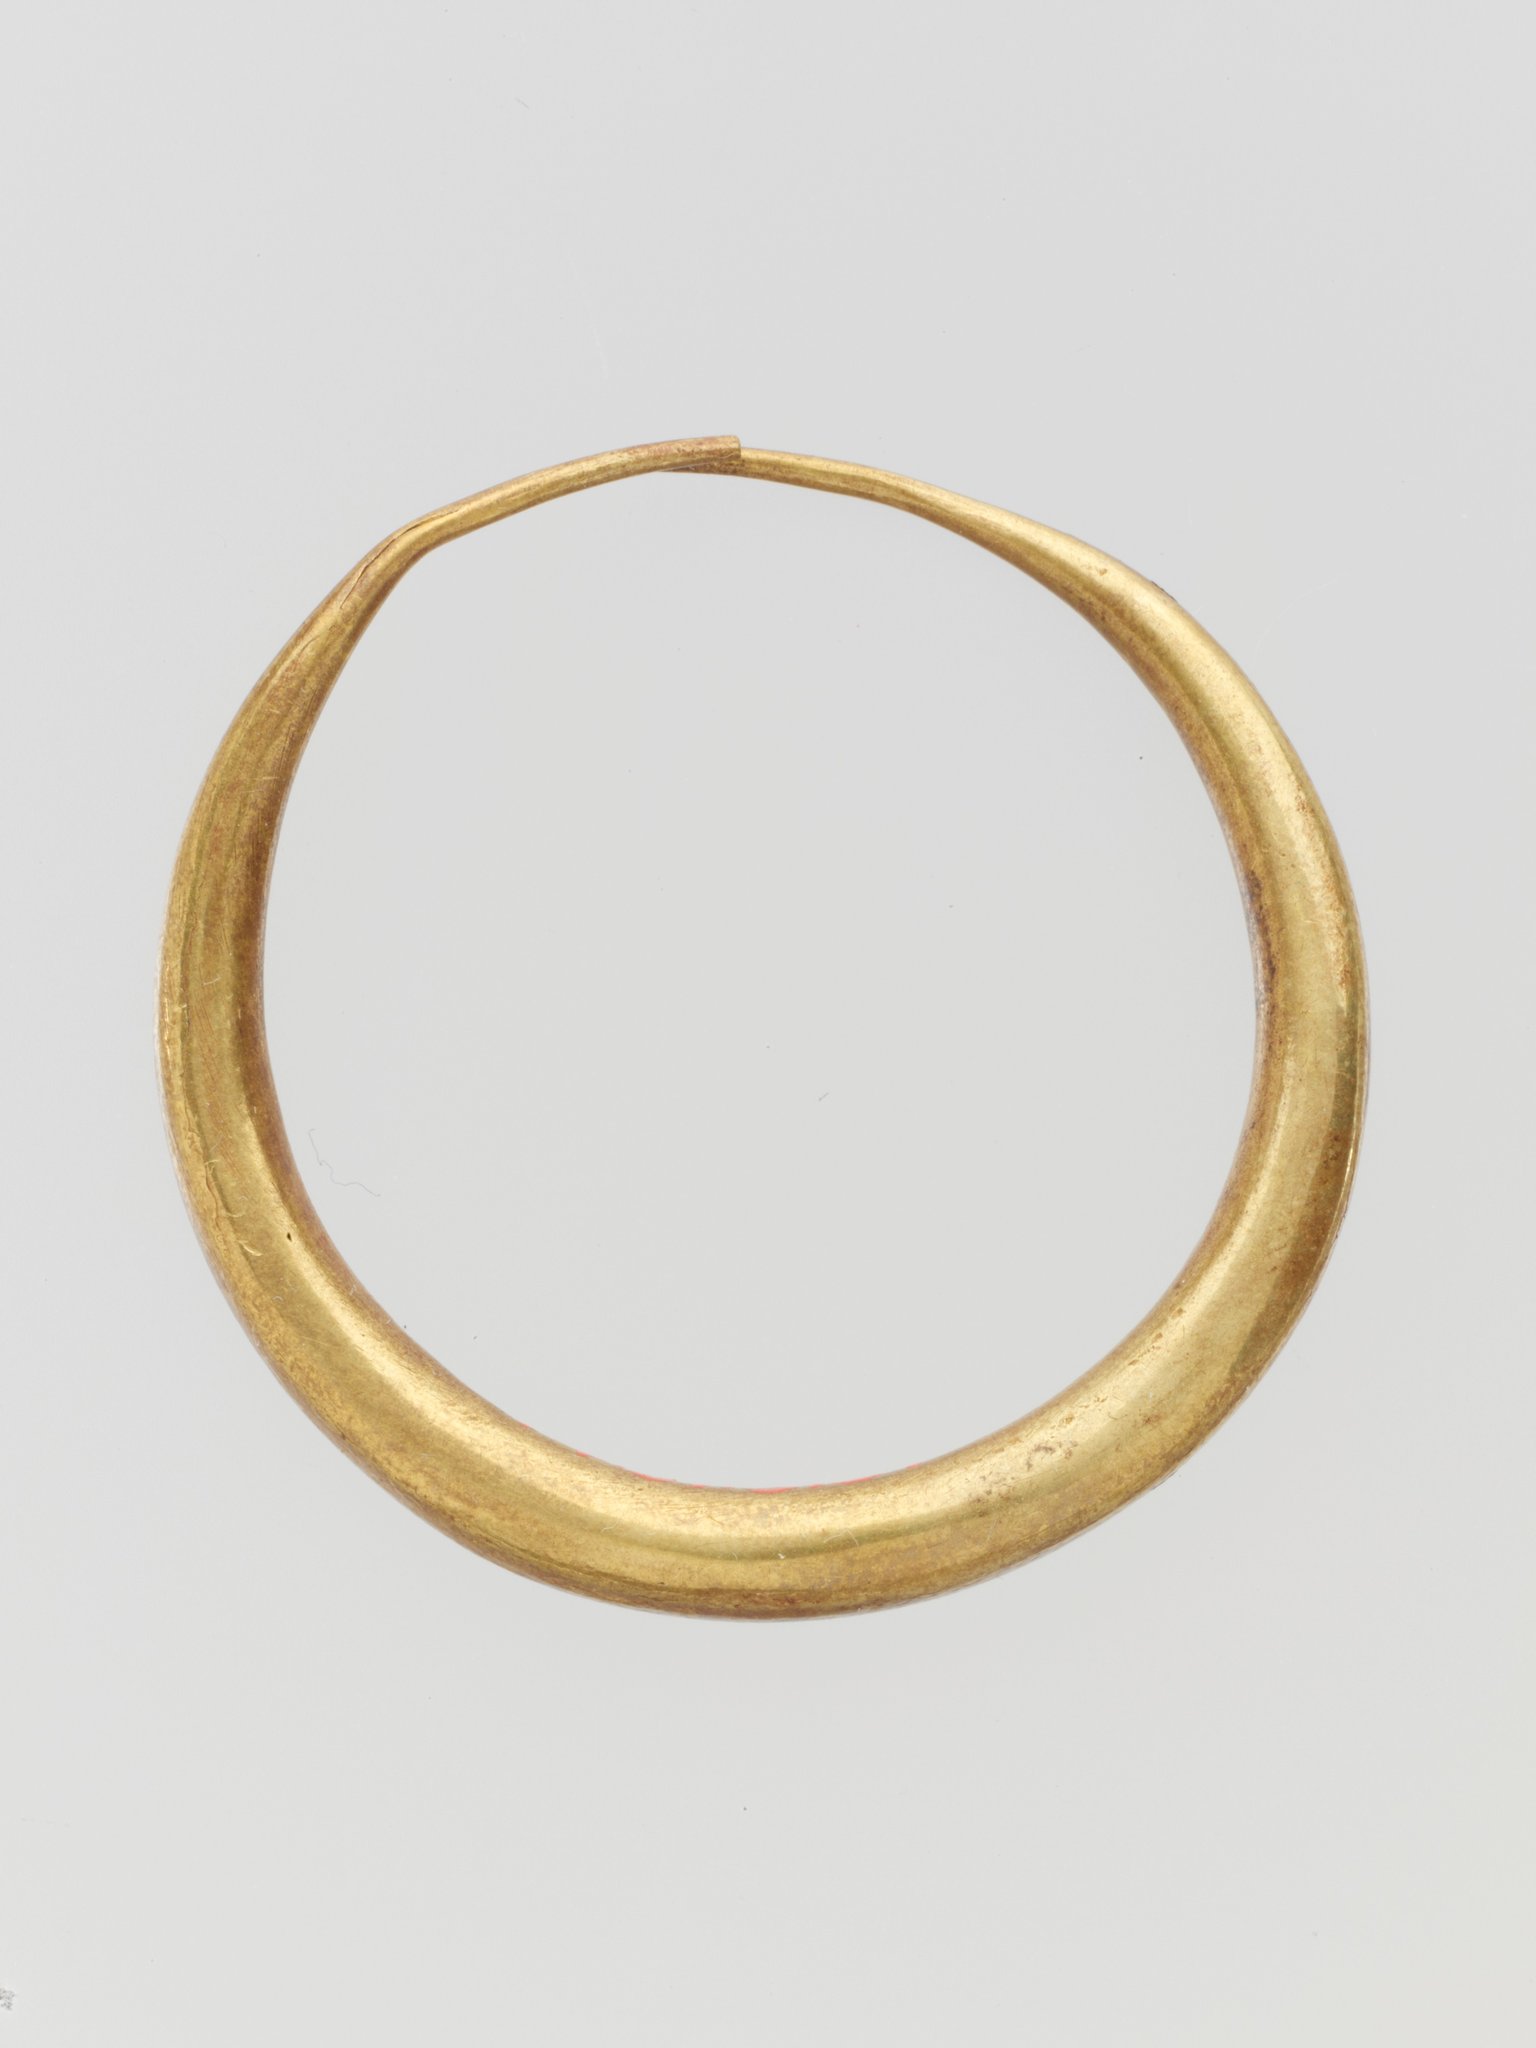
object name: earring of simple form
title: Gold annular earring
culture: cypriot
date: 1600-1050 BCE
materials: gold